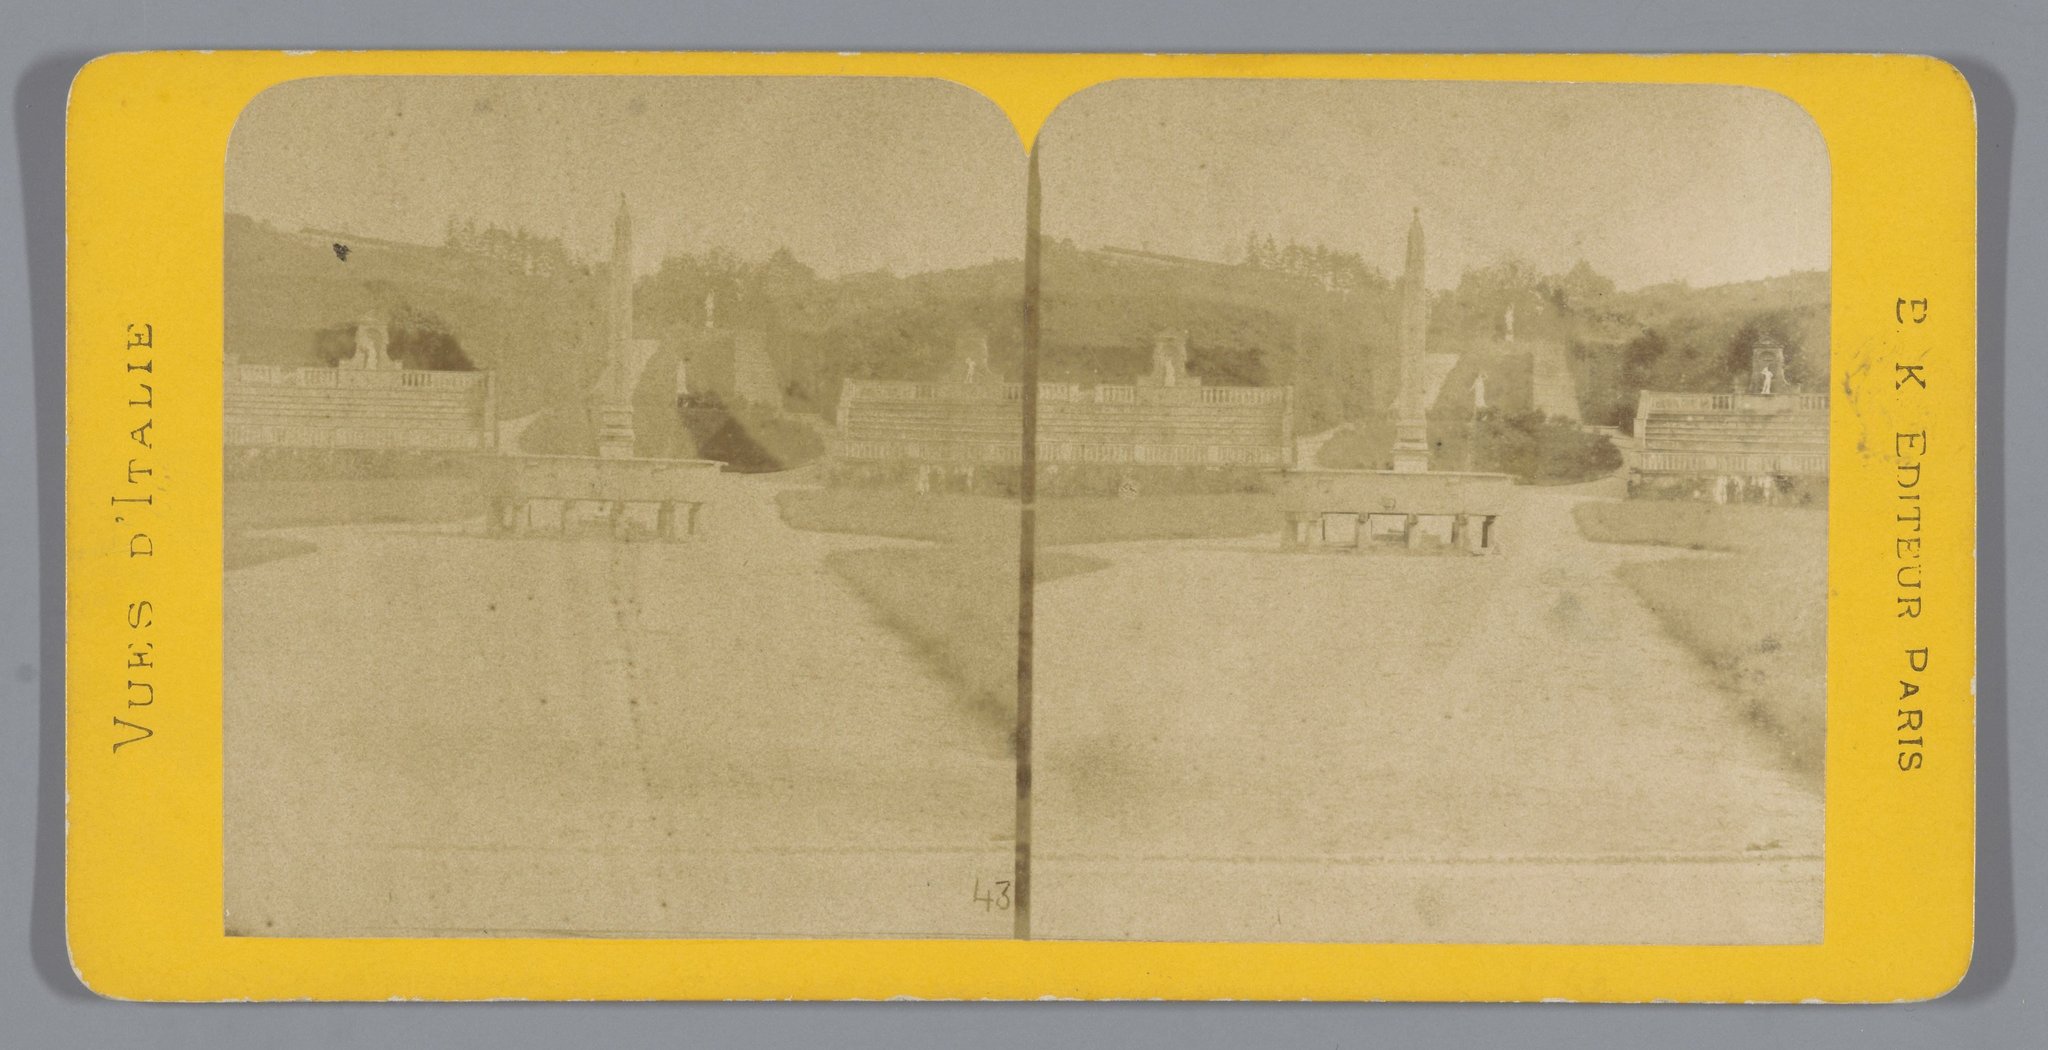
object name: stereograph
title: Gezicht op de Boboli-tuinen te Florence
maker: Anonymous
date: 1850-1880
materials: cardboard, photographic support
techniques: albumen print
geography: giardino di boboli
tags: obelisk, needle, french or architectonic garden; formal garden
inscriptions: inscription: ‘Vues d'Italie’, inscription: ‘Jardins Boboli Florence’, number: ‘43’